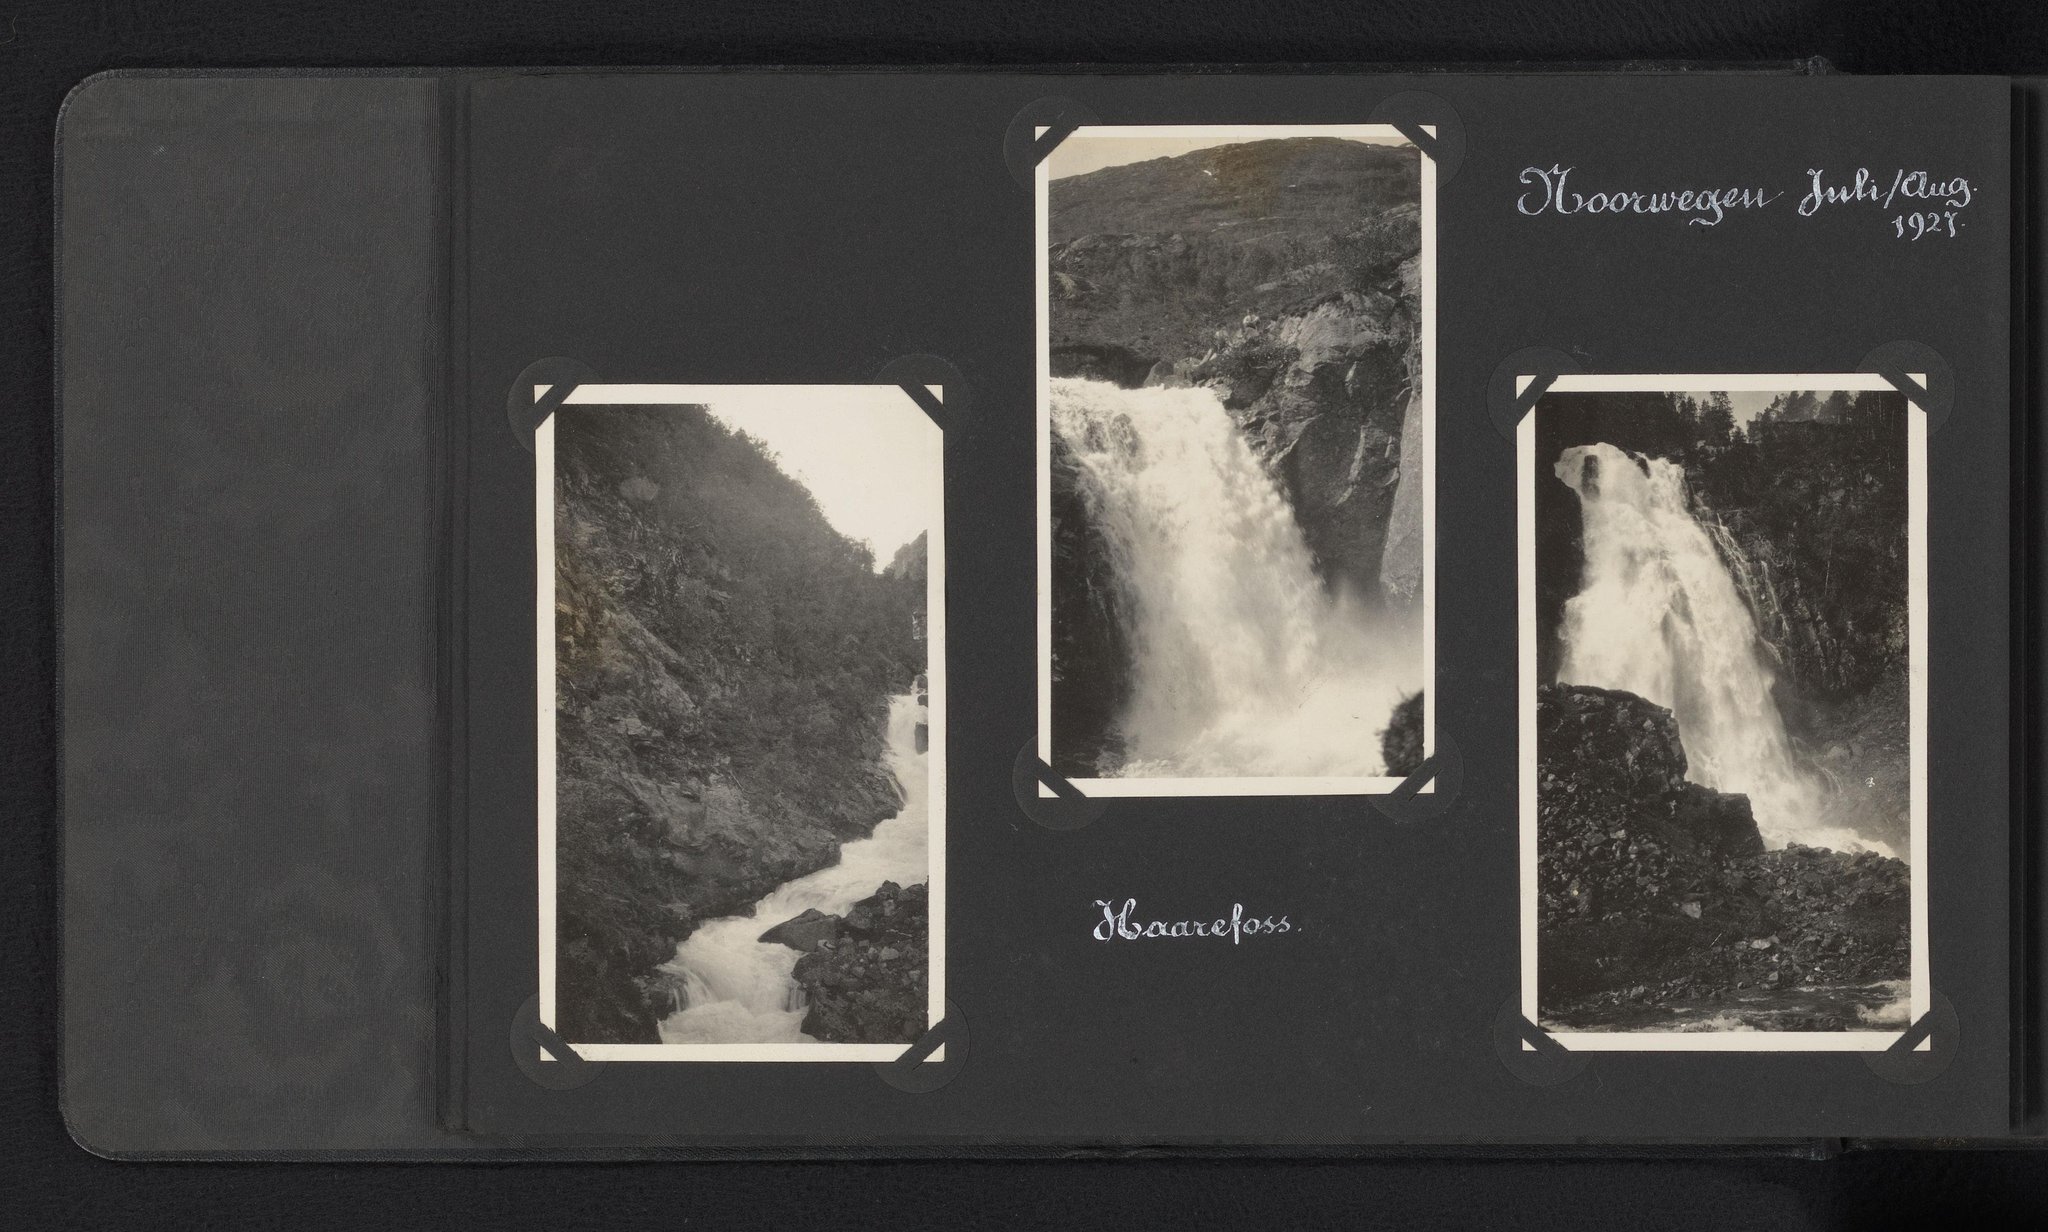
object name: album leaf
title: Drie foto's van een waterval in Noorwegen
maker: hendrik herman van den berg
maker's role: amateurfotograaf, jurist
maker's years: 1875-1944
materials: paper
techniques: gelatin silver print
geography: norway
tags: waterfall, norway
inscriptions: inscription: ‘Haarefoss’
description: Deze foto's maken deel uit van een album.